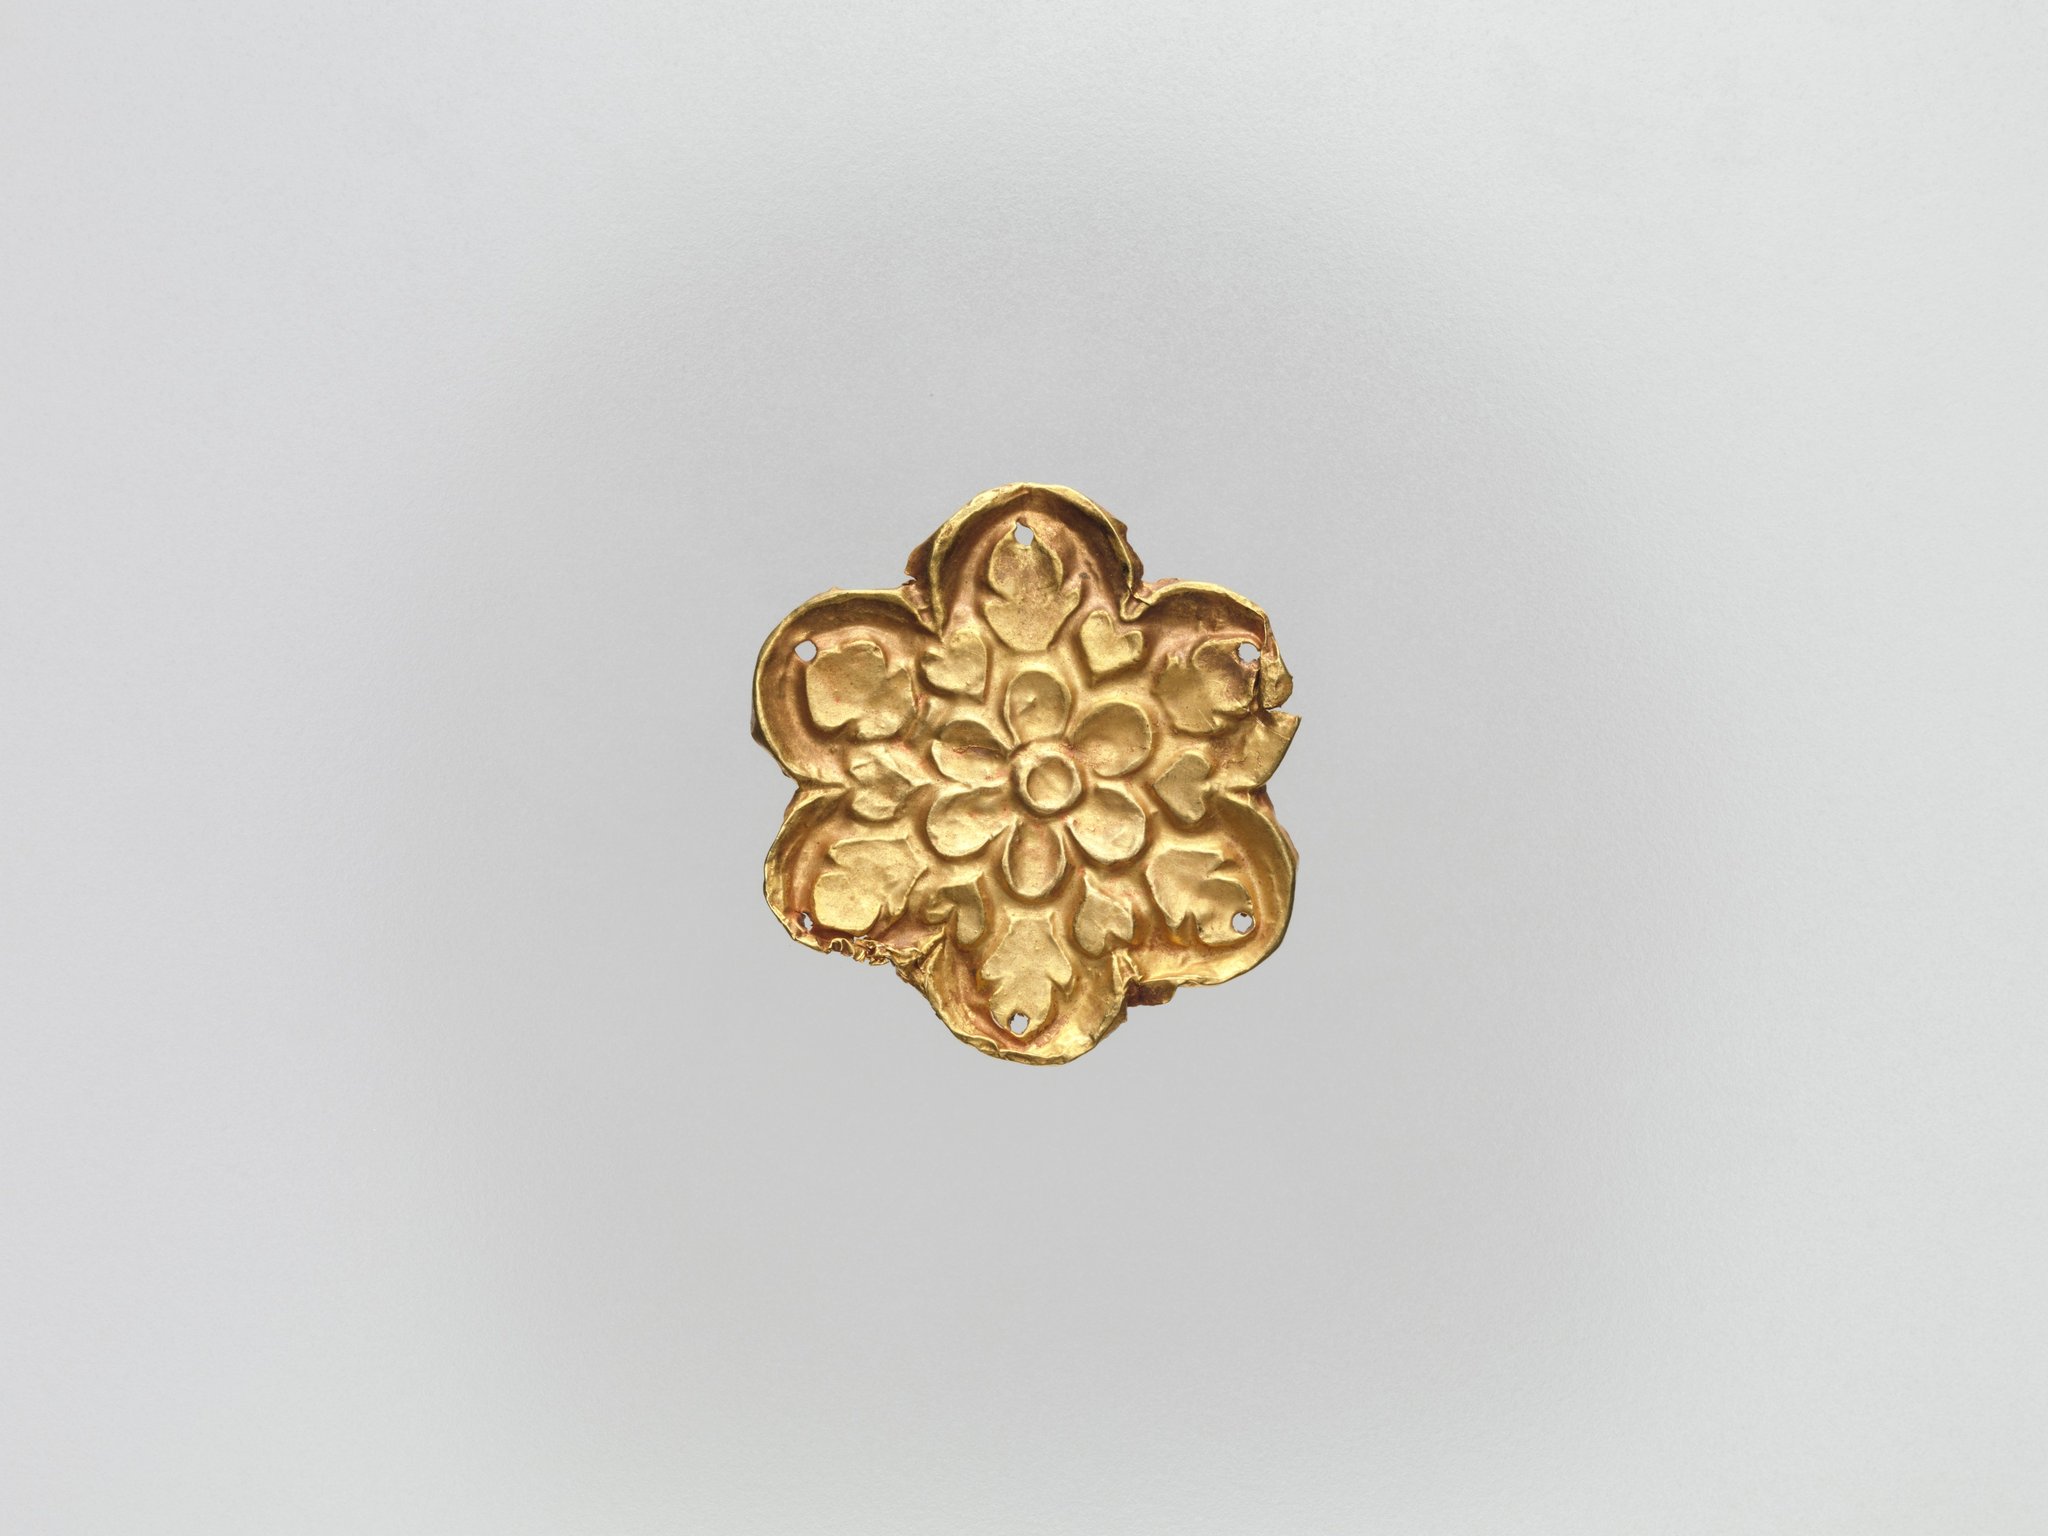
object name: garment plaque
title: Flower-Shaped Clothing Plaque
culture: chinese or central asian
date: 601-900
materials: gold